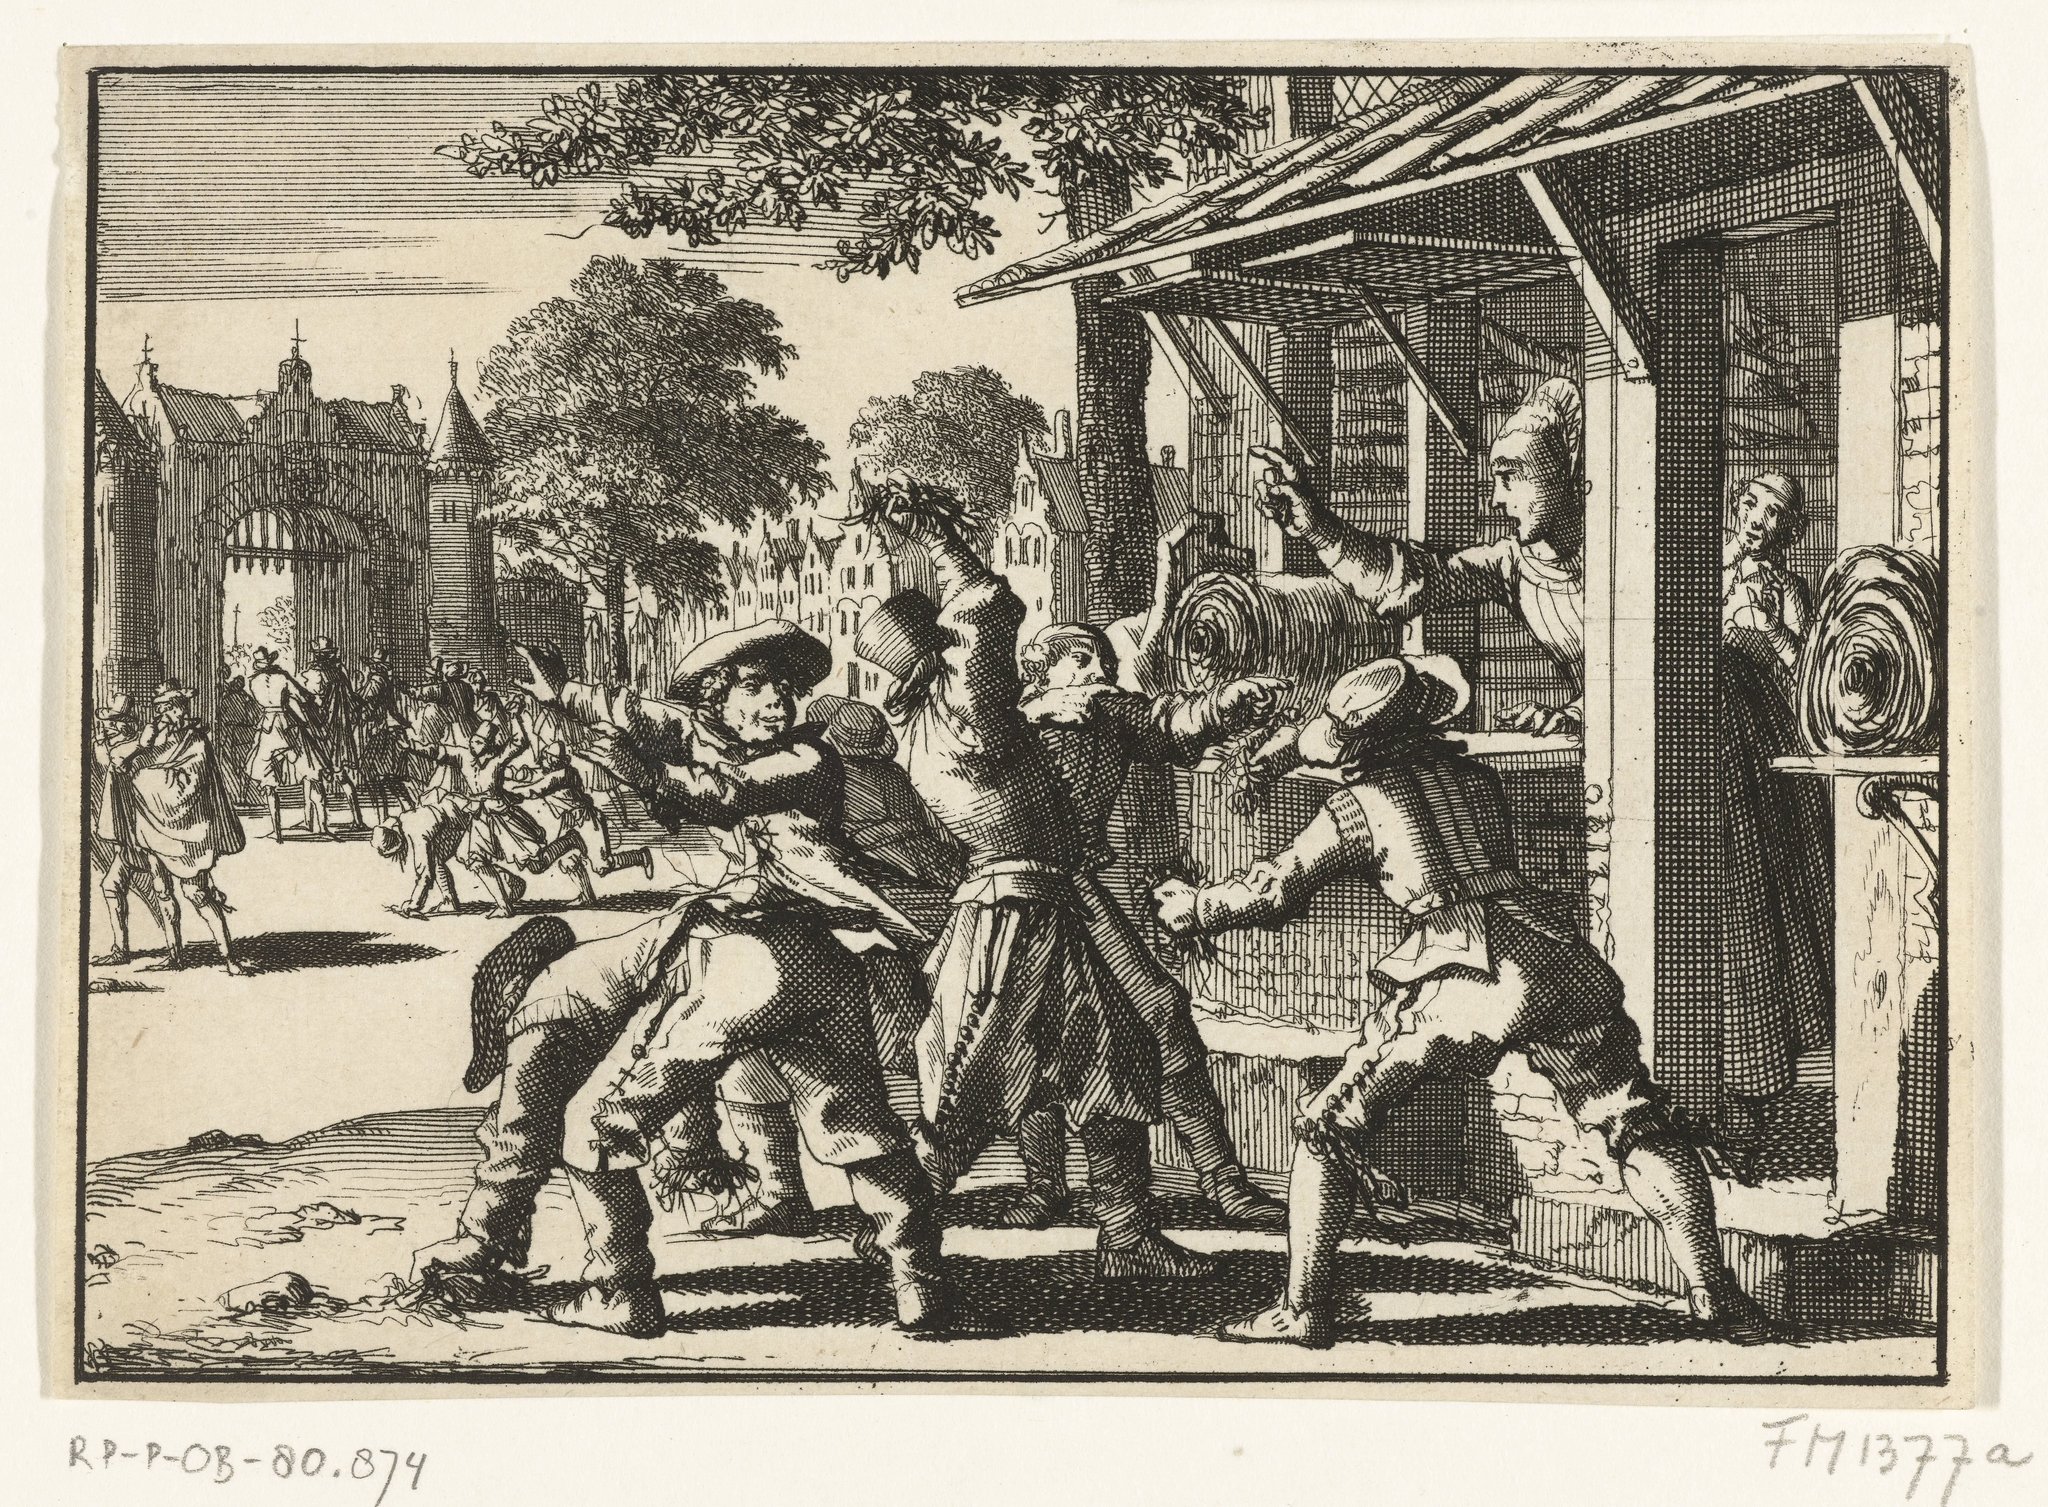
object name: print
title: De winkels van contraremonstranten te Schoonhoven worden aangevallen en met vuil geworpen, 1617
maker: jan luyken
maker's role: draughtsman, print maker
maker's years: 1649-1712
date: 1696-1700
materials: paper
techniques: etching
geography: northern netherlands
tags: street-fights, riots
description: Te Schoonhoven worden de winkels van contraremonstranten die buiten de stad te kerk gaan door jongens aangevallen en met vuil geworpen, 1617. Op de achtergrond verlaten contraremonstranten door de poort de stad, op de voorgrond wordt een open stoffenwinkel met luifel door jongeren bekogeld met straatafval. Deze voorstelling door Muller (abusievelijk) geïnterpreteerd als de arrestatie van de remonstrantse predikant D. Sapma en het oproer te Hoorn, 10 maart 1619.